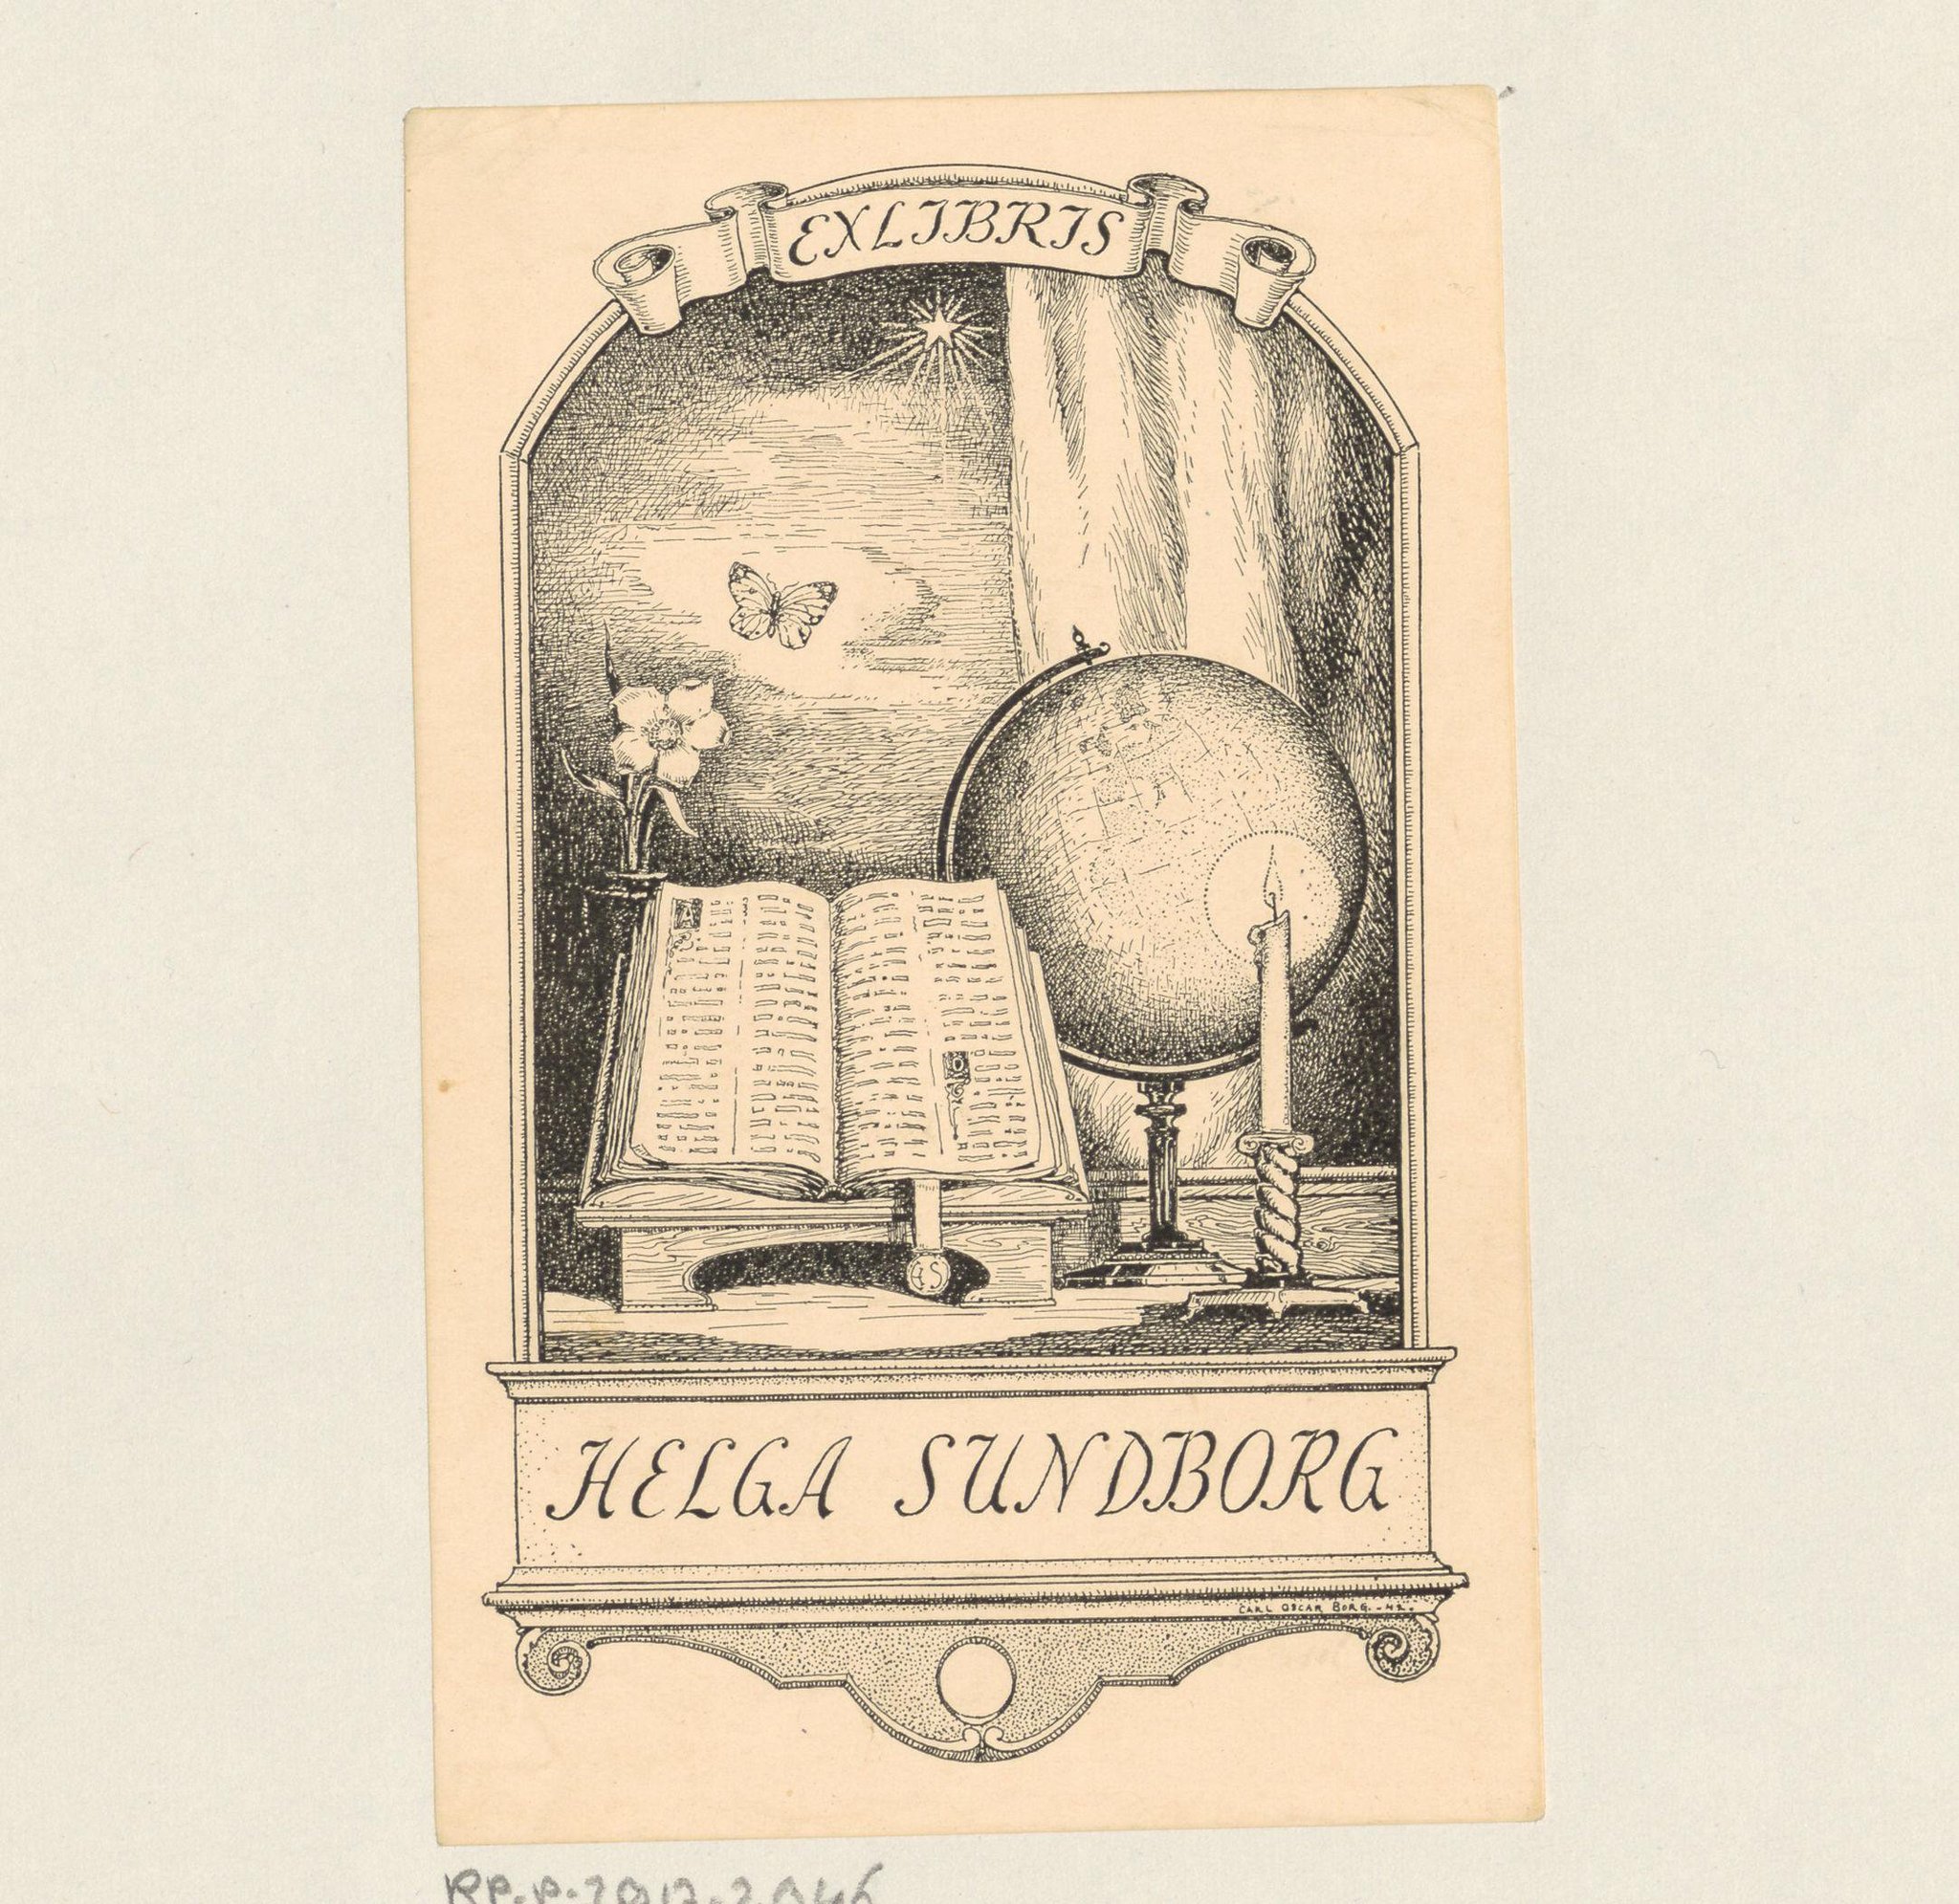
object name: bookplate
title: Ex libris van Helga Sundborg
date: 1942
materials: paper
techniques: printing block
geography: sweden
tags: curtains, book, candle, stars, insects: butterfly, globe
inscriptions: inscription: ‘29-30 1/5 (?) / Geo Bay 1942 (?) Bed 30655 / Carl Oscar Borg 1942’